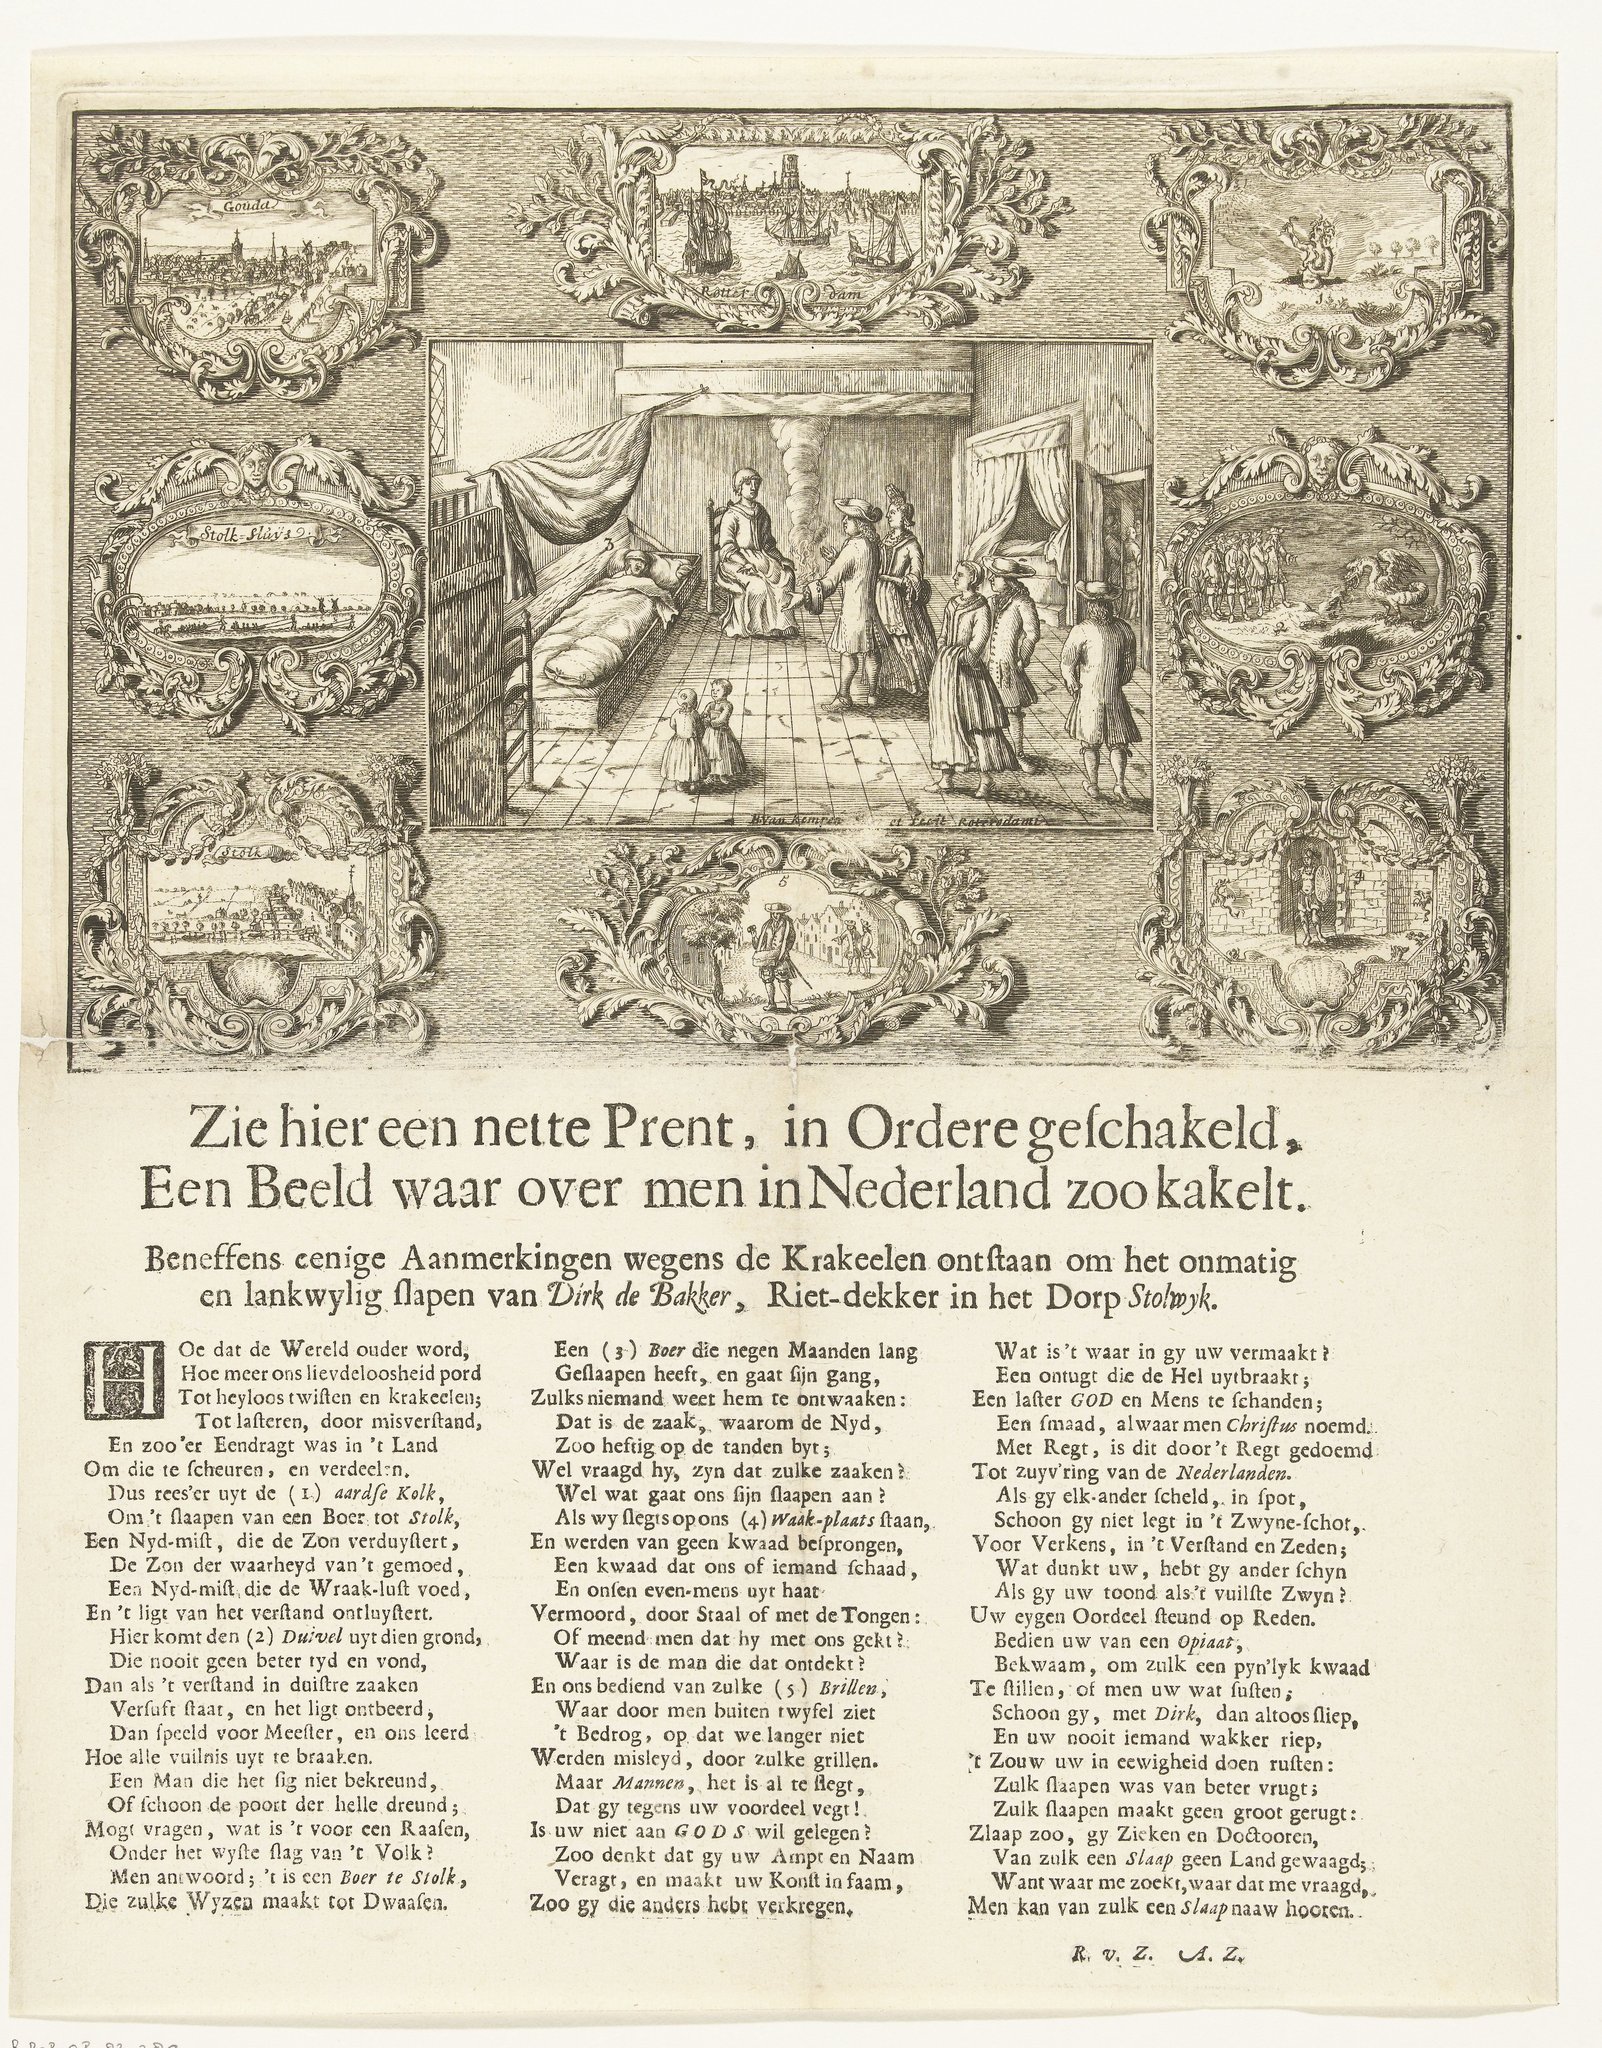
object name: cartoon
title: De slapende boer van Stolwijk, 1707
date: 1707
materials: paper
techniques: etching, letterpress printing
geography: rotterdam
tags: sleeping in bed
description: De slapende boer van Stolwijk, of de zgn. slapende Stolkse boer. Dirk Klaasz de Bakker sliep van 29 juni 1706 tot 11 januari 1707 (27 weken) en is na het wekken weer ingeslapen tot 15 maart 1707. Centraal het bed met de slapende man met enkele bezoekers. Deze voorstelling omringd door acht kleinere scènes met stadsgezichten en emblemen. Gedrukt op het blad onder de plaat een vers in 3 kolommen.